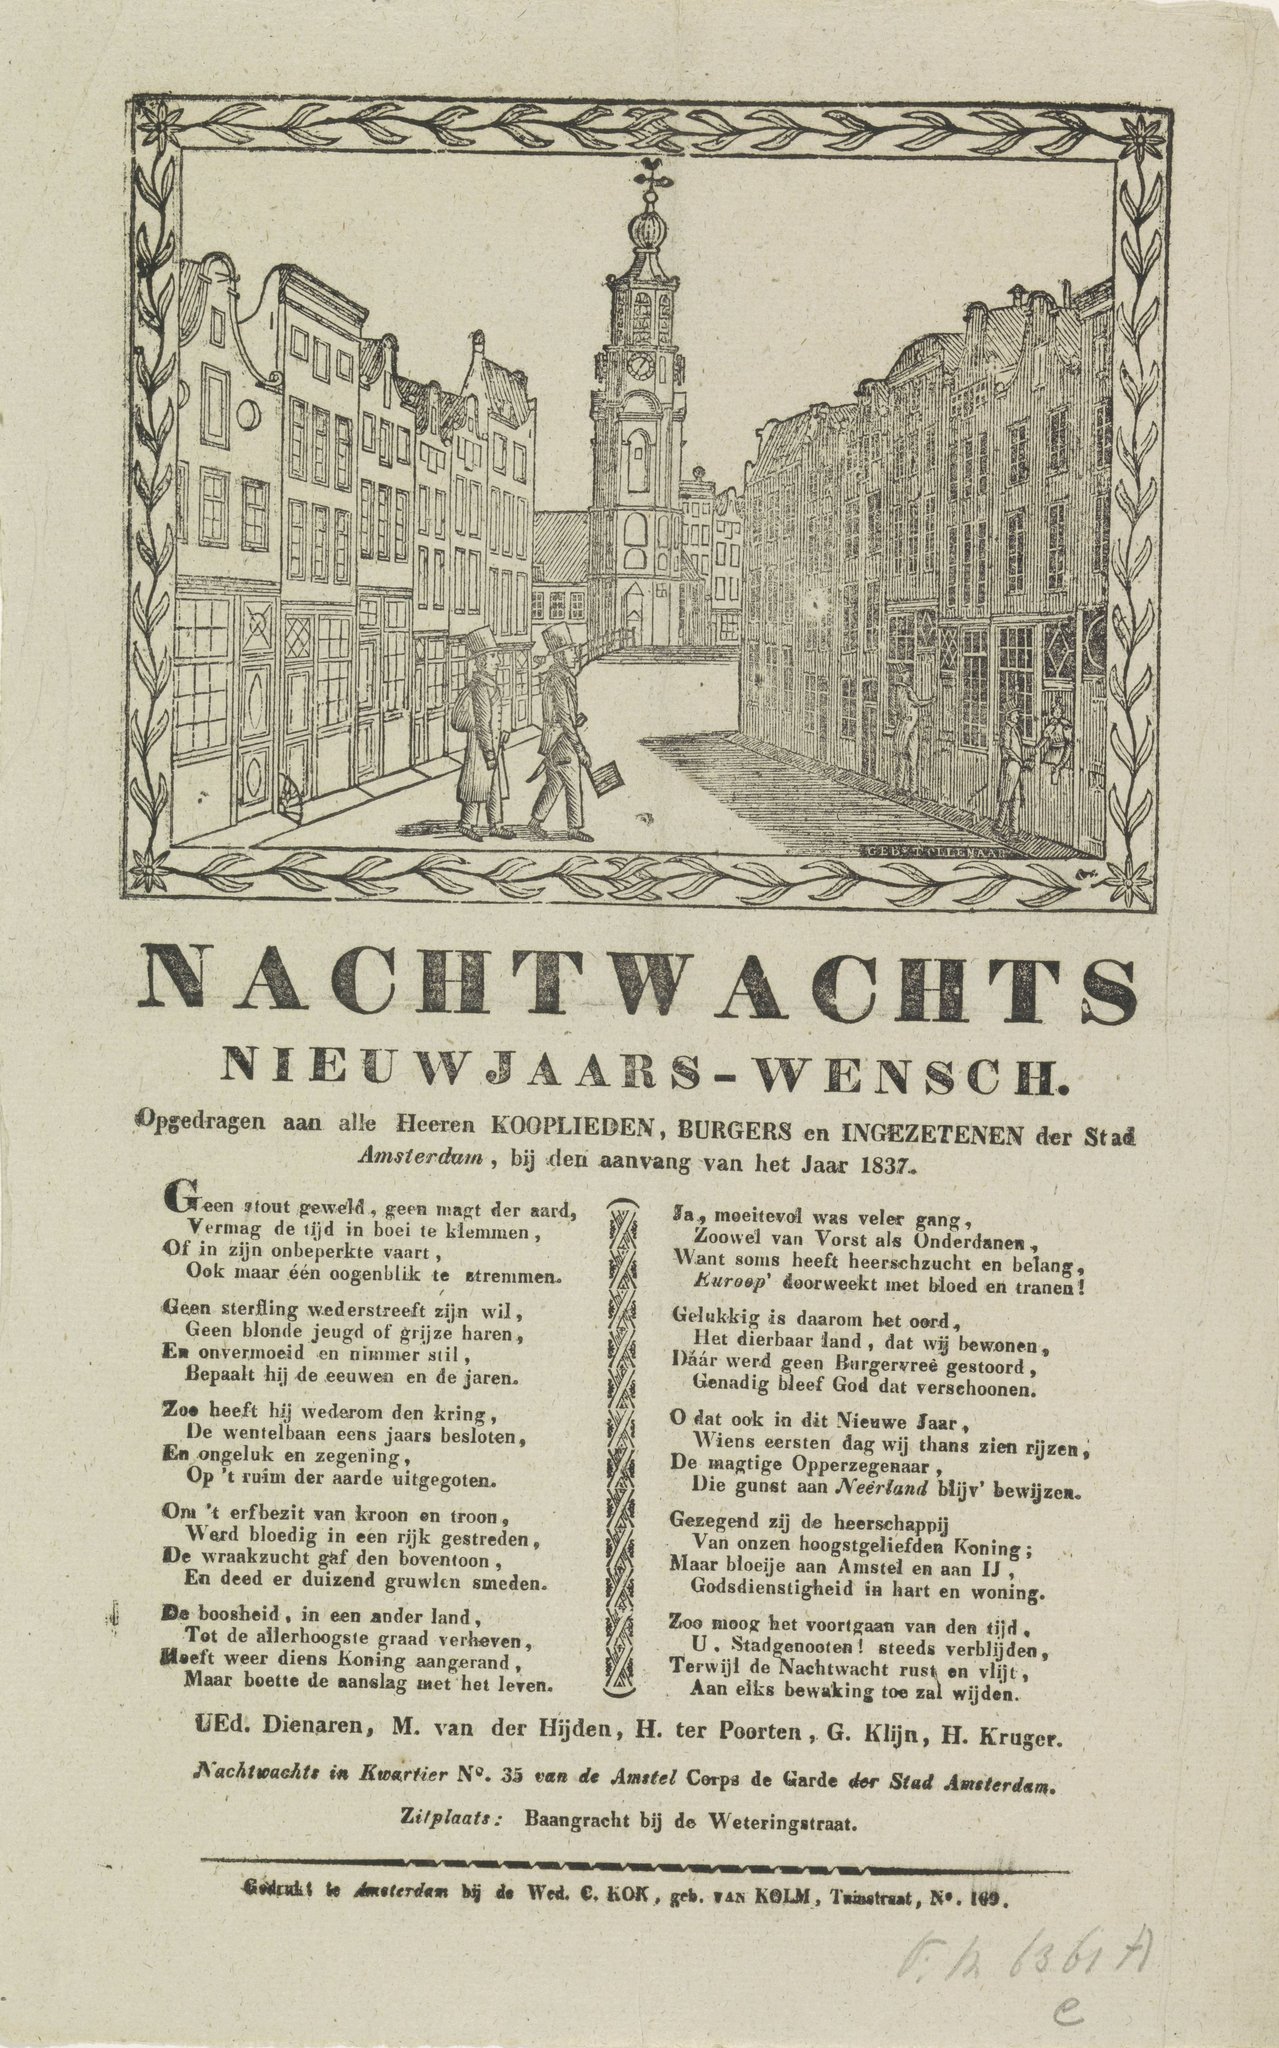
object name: new year card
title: Nieuwjaarswens van de Amsterdamse nachtwacht voor het jaar 1837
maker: weduwe c. kok geboren van kolm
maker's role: printer, publisher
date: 1836-1837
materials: paper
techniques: letterpress printing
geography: amsterdam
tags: night patrol, street, amsterdam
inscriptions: collector's mark: Lugt 2228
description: Nieuwjaarswens van de Amsterdamse nachtwacht (ratelwacht) voor het jaar 1837. Twee leden van de nachtwacht lopend met een ratel door een straat (Reguliersbreestraat?) bij de Munt in Amsterdam. Met een vers in twee kolommen. Namens de nachtwacht in kwartier No. 35 van de Amstel Corps de Garde der stad Amsterdam: M. van der Hijden, H. ter Poorten, G. Klijn en H. Kruger.